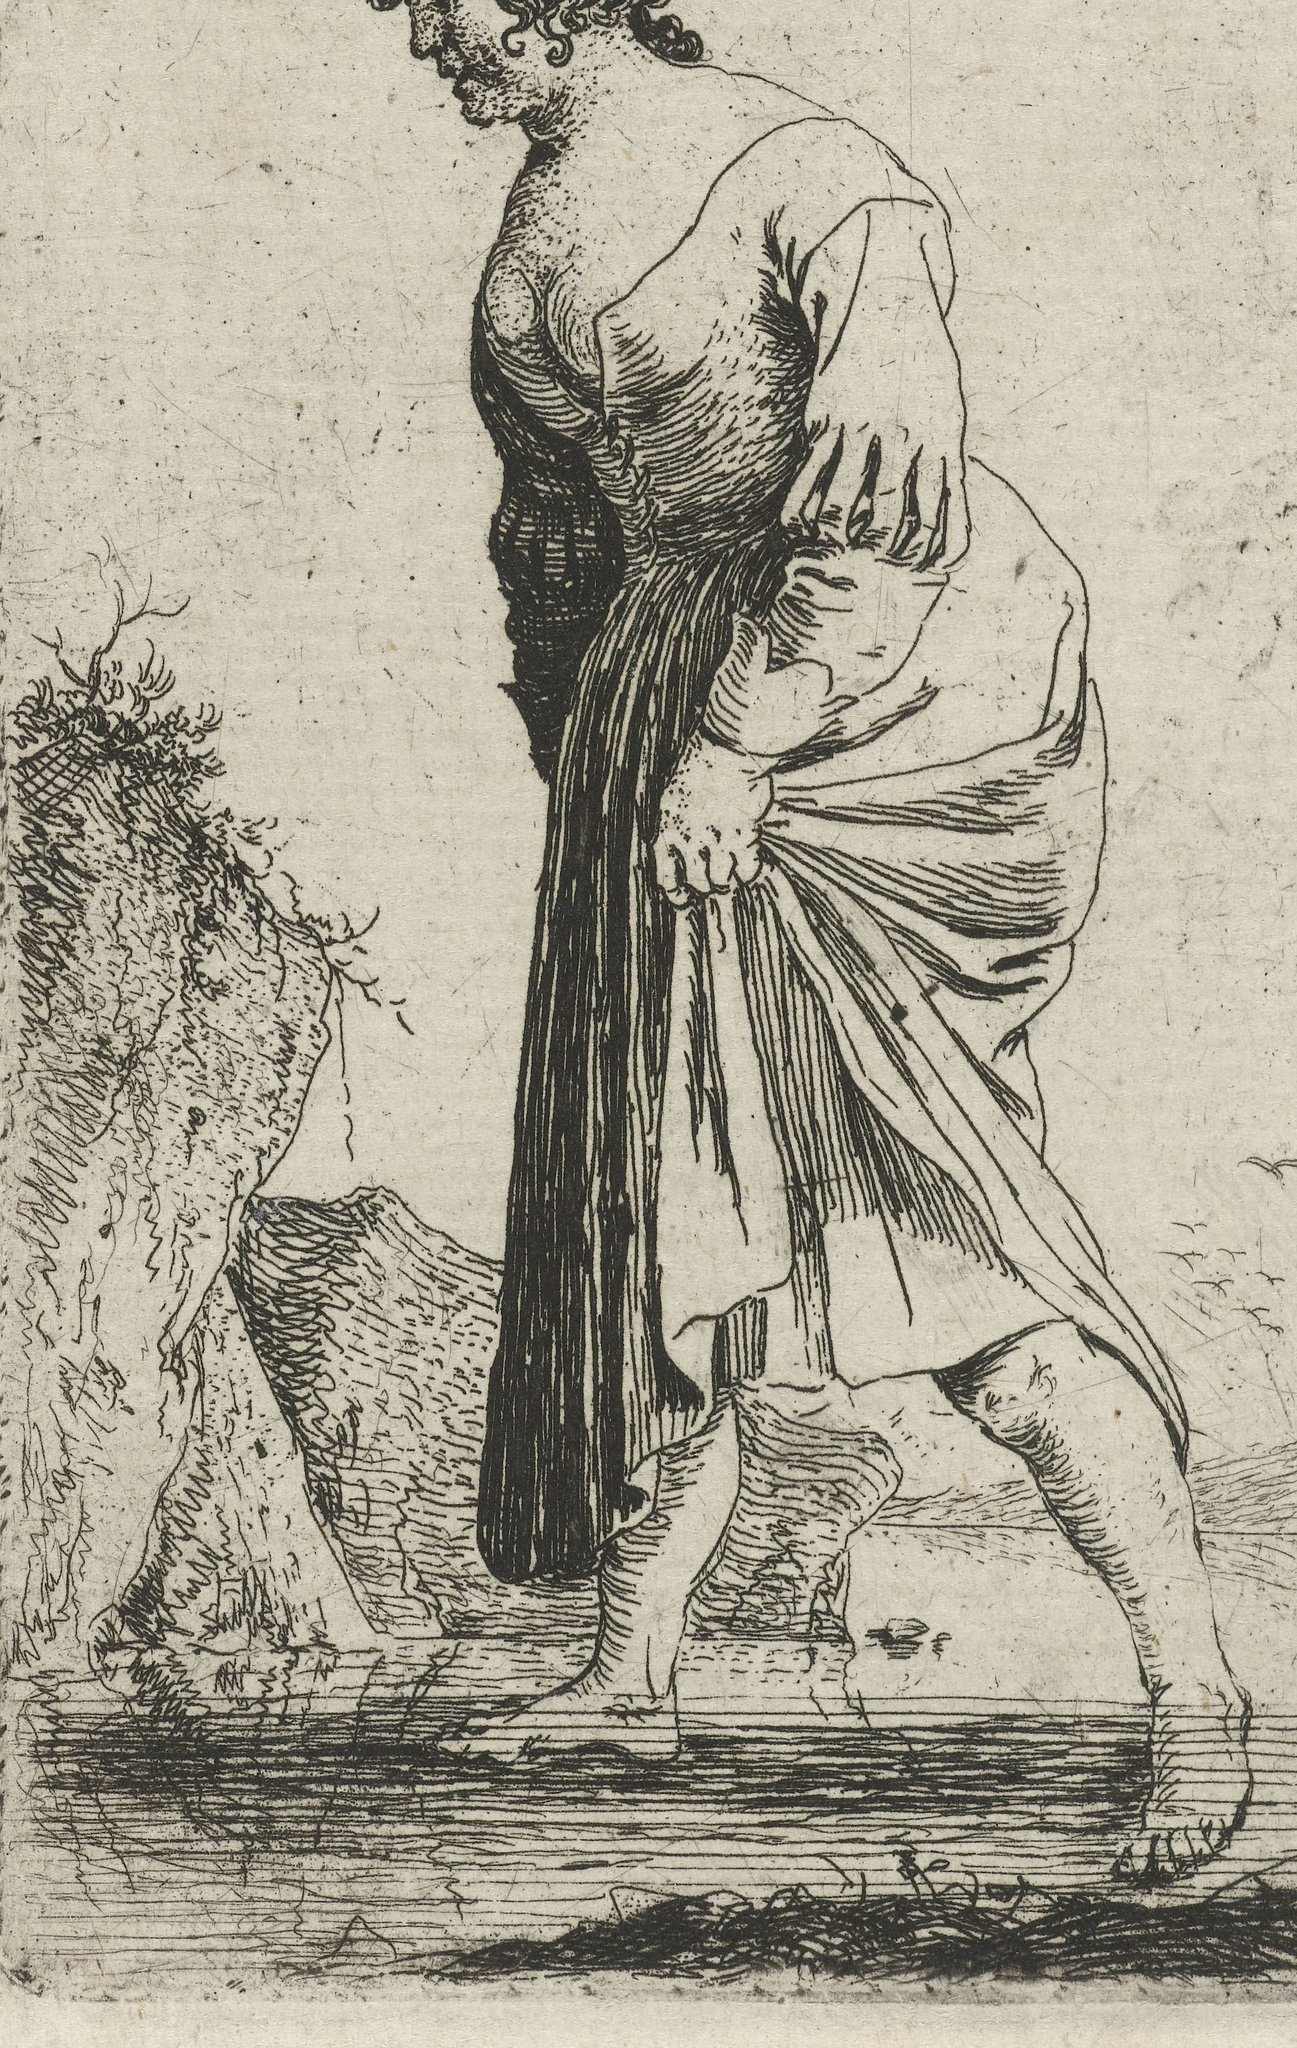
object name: print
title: Vrouw wadend door een beek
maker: jan van den hecke (ii)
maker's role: print maker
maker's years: 1661-1722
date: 1671-1710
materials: paper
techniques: etching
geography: southern netherlands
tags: adult woman, brook, wading, paddling - aa - female human figure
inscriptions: collector's mark: Lugt 2228